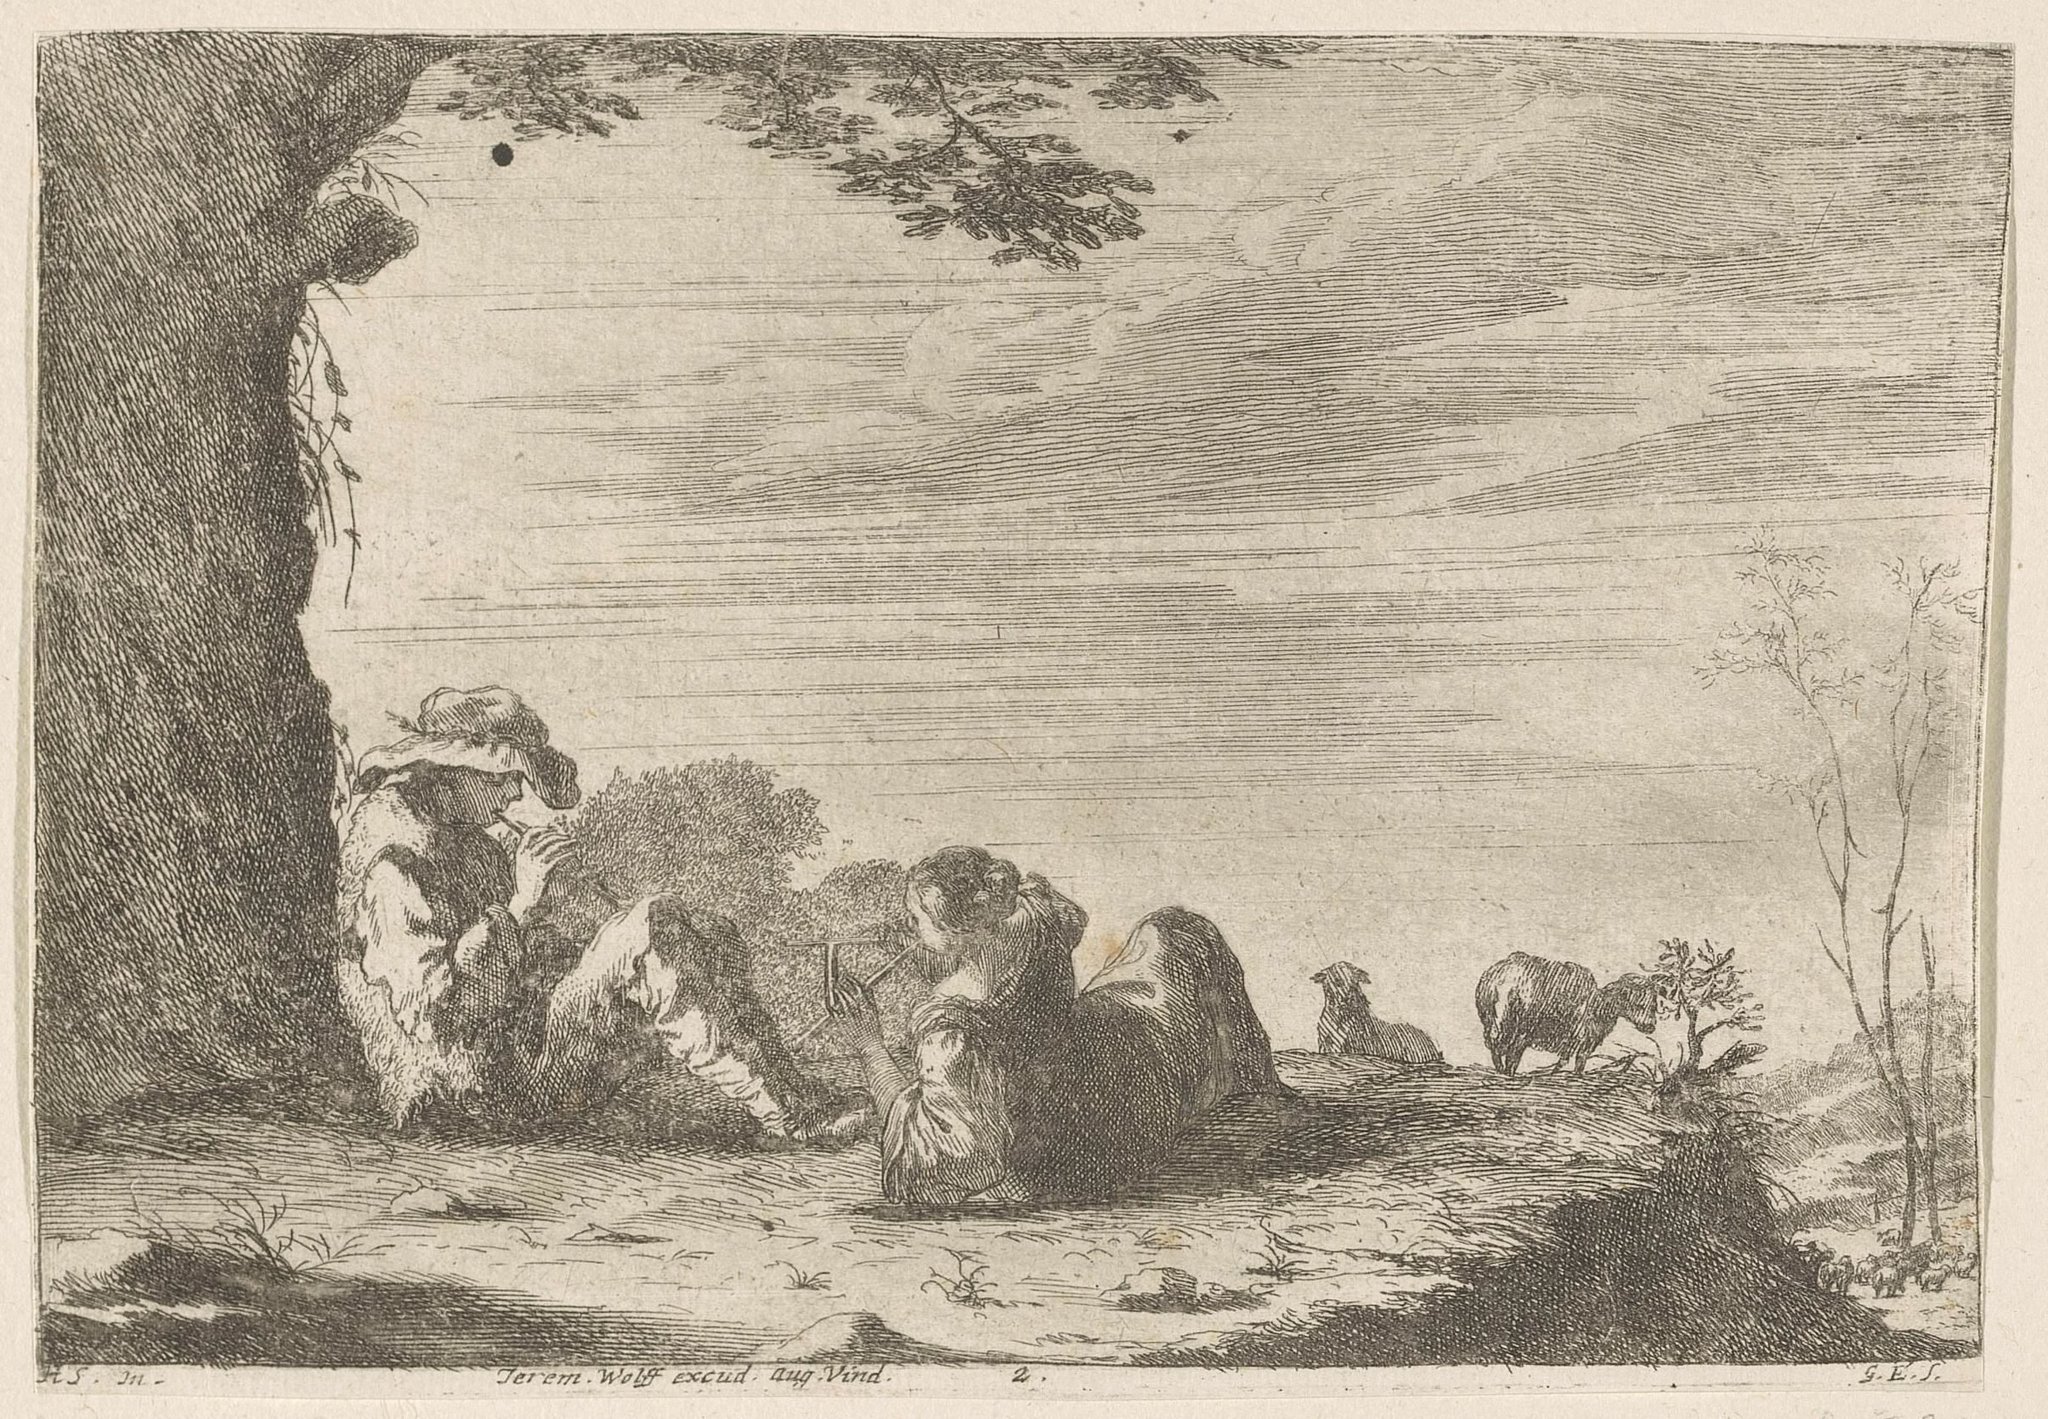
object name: print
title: Muziekmakende herders met schapen in rustiek landschap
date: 1673-1736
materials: paper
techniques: etching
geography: augsburg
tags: herding, herdsman, herdswoman, shepherd, shepherdess, cowherd, etc., sheep, resting - bb - out of doors, landscapes - hh - ideal landscapes, more than one musician with instrument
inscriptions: number: ‘0065’, collector's mark: Lugt 2228, collector's mark: Lugt 2760